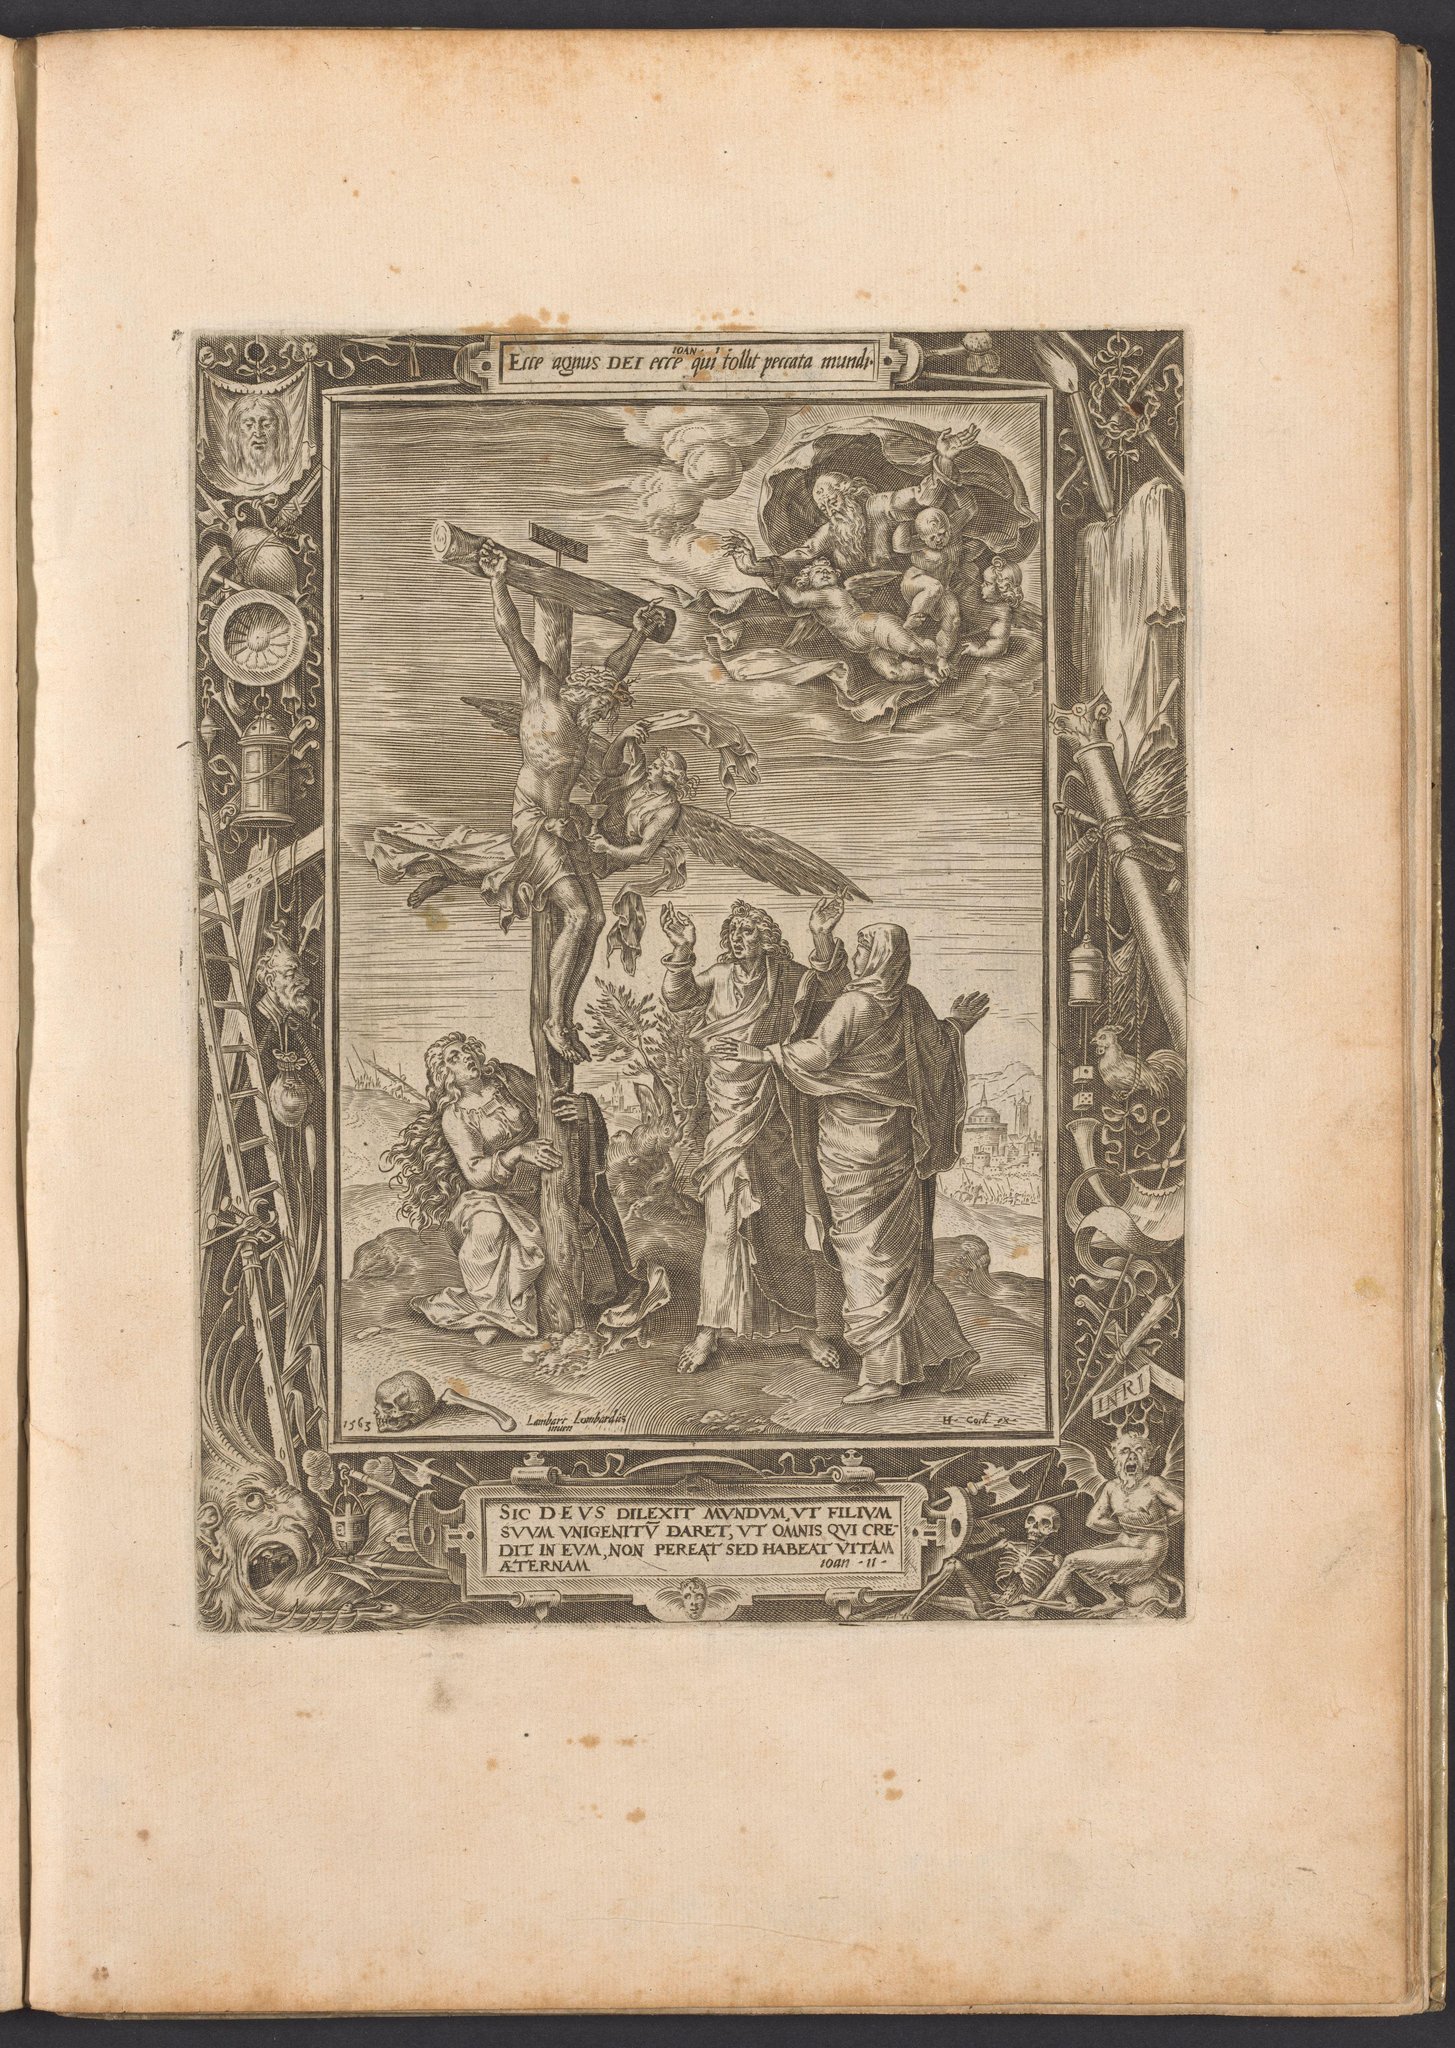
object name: album leaf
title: Kruisiging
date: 1563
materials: paper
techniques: engraving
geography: antwerp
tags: crucified christ, with particular persons under the cross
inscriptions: date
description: Christus hangt aan het kruis. Een engel vangt zijn bloed op in een kelk. Rechtsboven God de Vader met enkele engelen. Voor het kruis staan Johannes de Evangelist en Maria. Maria Magdalena houdt het kruis vast. Rond de voorstelling een ornamentrand met de passiewerktuigen. Boven een cartouche met een eenregelige tekst in het Latijn uit Joh. 1. Onder een cartouche met een vierregelige tekst in het Latijn uit Joh. 11. Deze prent maakt deel uit van een album.